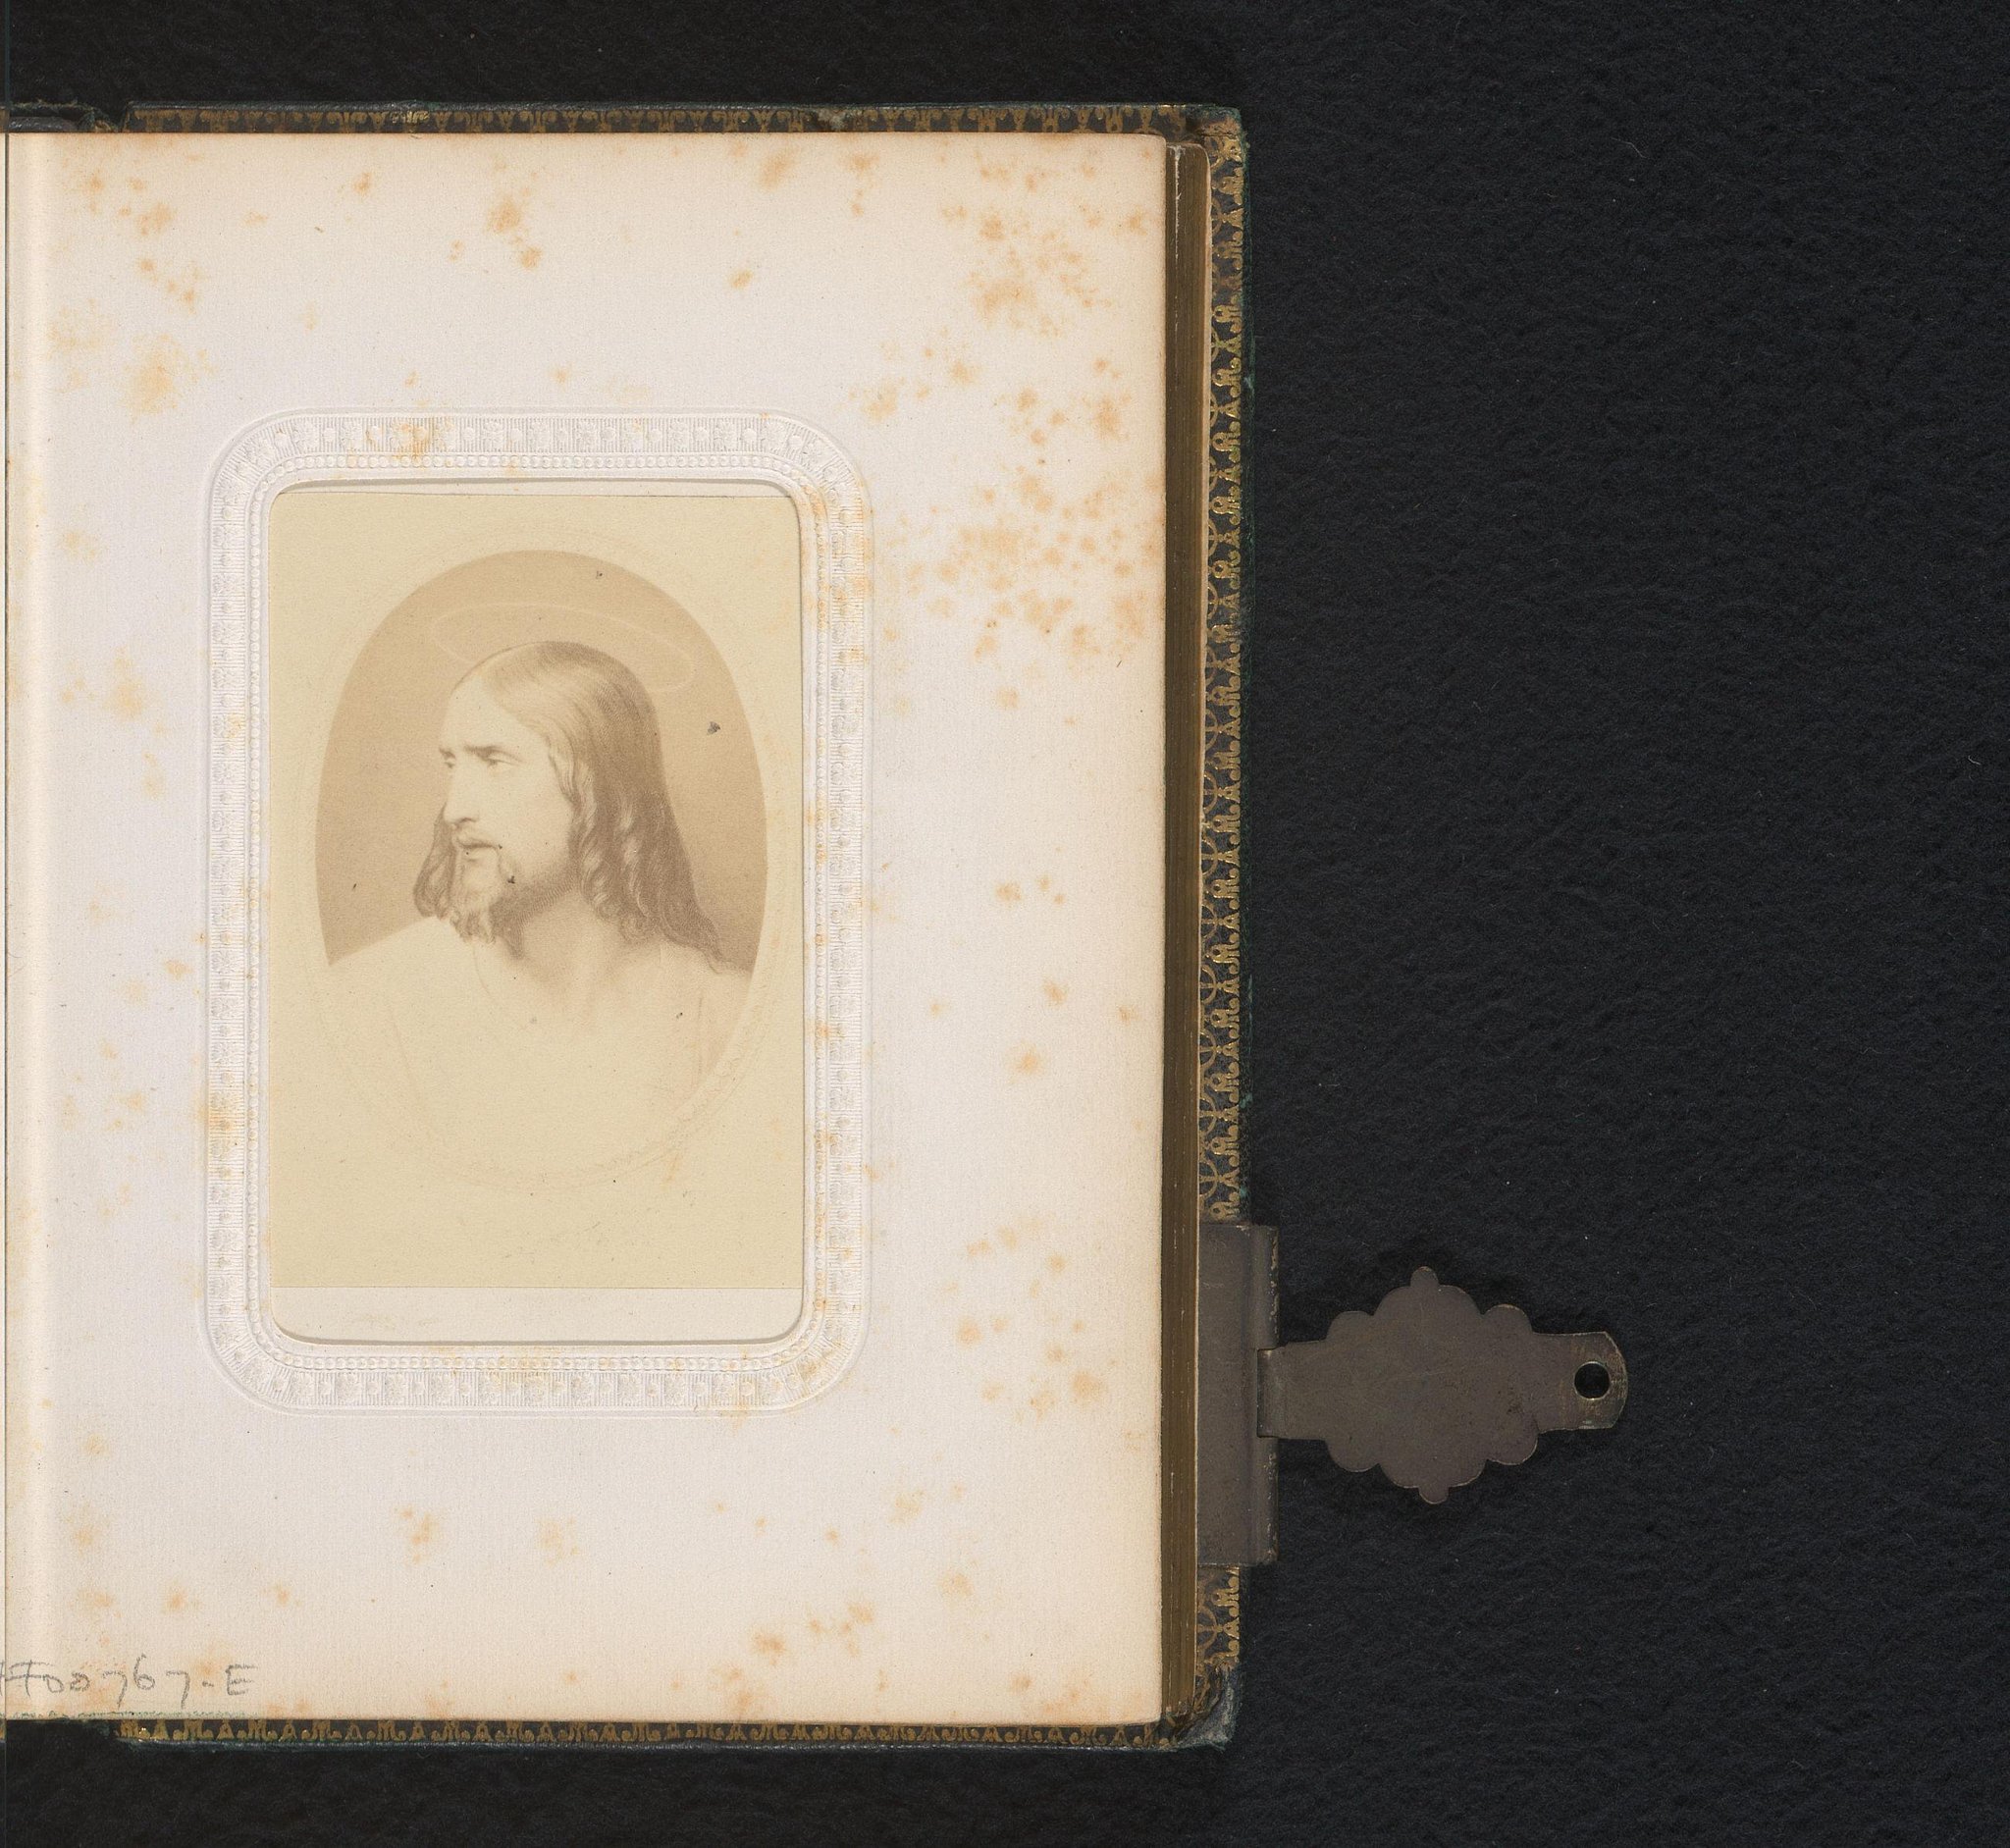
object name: album leaf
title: Fotoreproductie van een schilderij van Christus door Paul Delaroche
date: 1861-1878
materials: cardboard, photographic support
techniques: albumen print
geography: paris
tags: 'portraits' of christ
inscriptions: inscription: ‘PHOTOGRAPHIE GOUPIL & Cie/ PARIS, 19, Bd Montmartre./ LONDRES-LA HAYE-BERLIN-NEW YORK’